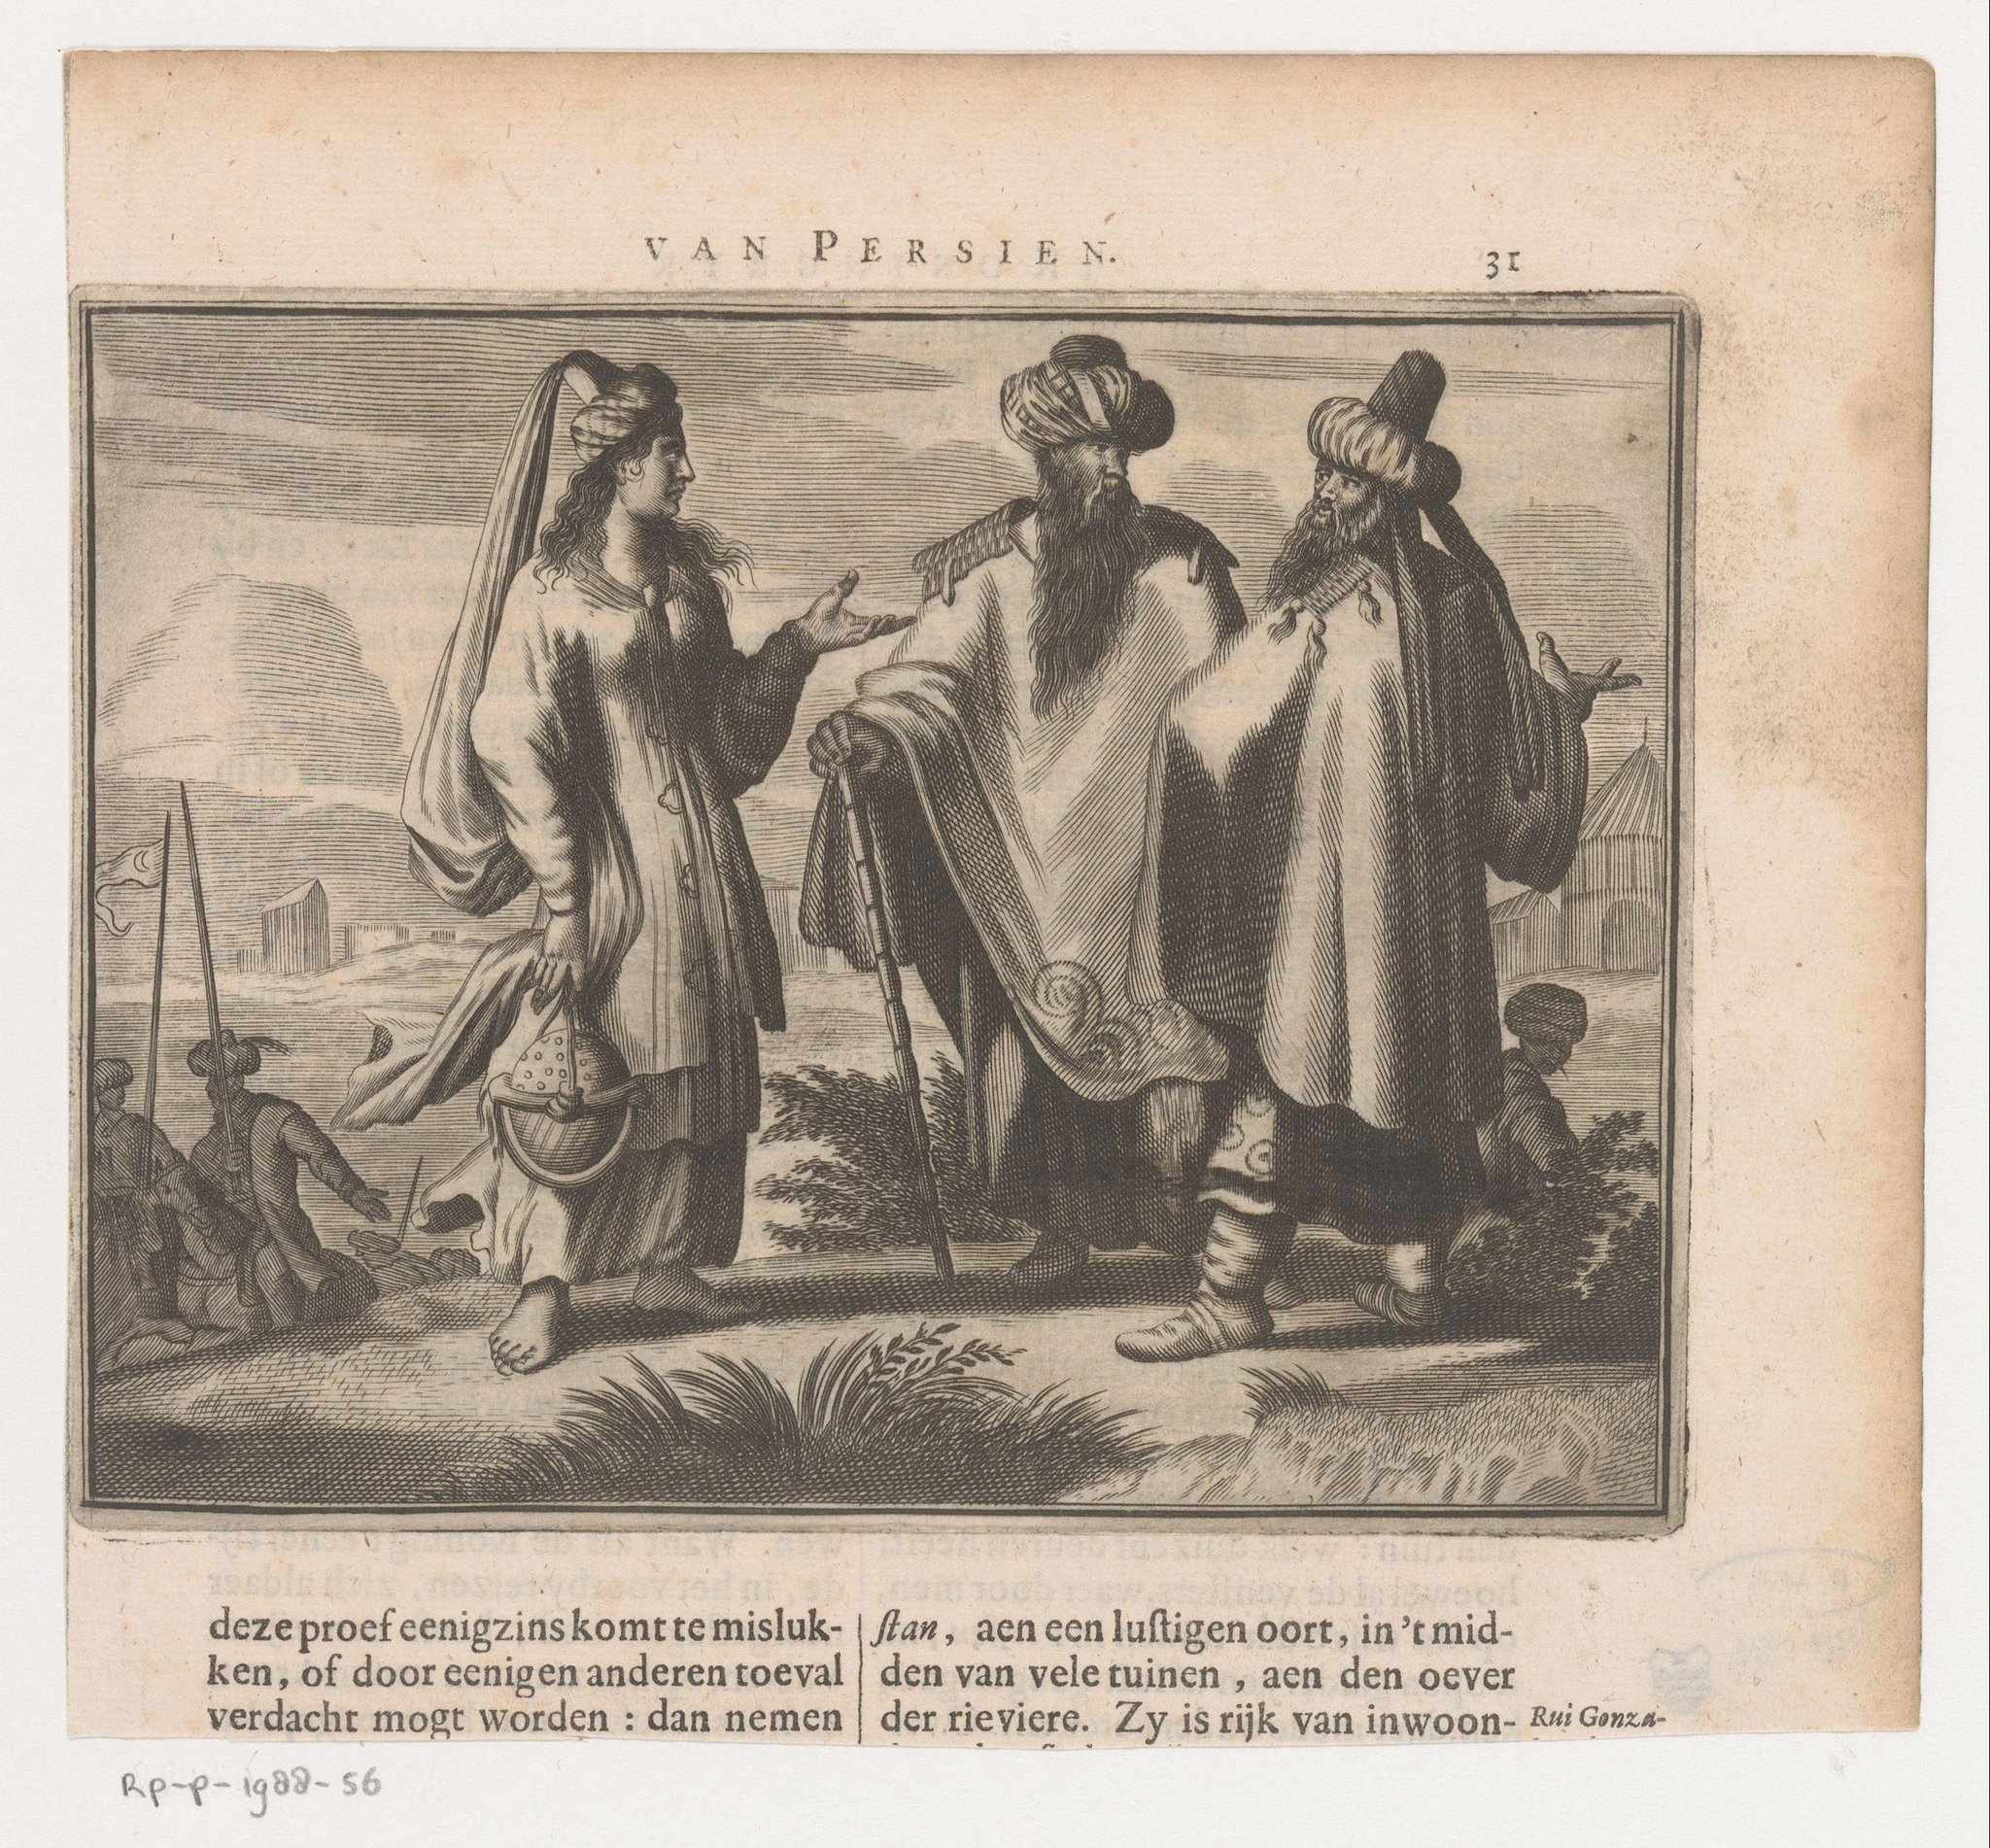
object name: book illustration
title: Perzische klederdracht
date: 1672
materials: paper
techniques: engraving, letterpress printing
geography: amsterdam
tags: human types; peoples and nationalities, merchant, salesman, persia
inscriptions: collector's mark: Lugt 2228, collector's mark: Lugt 2760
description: Prent uit: Dapper, Olfert. Beschrijving des koningrycks van Persie, behelsende de landschappen Fars, Schirwan, Erak, Adirbeitzan, Karabach (...). Amsterdam: Jacob van Meurs, 1672, p. 31.